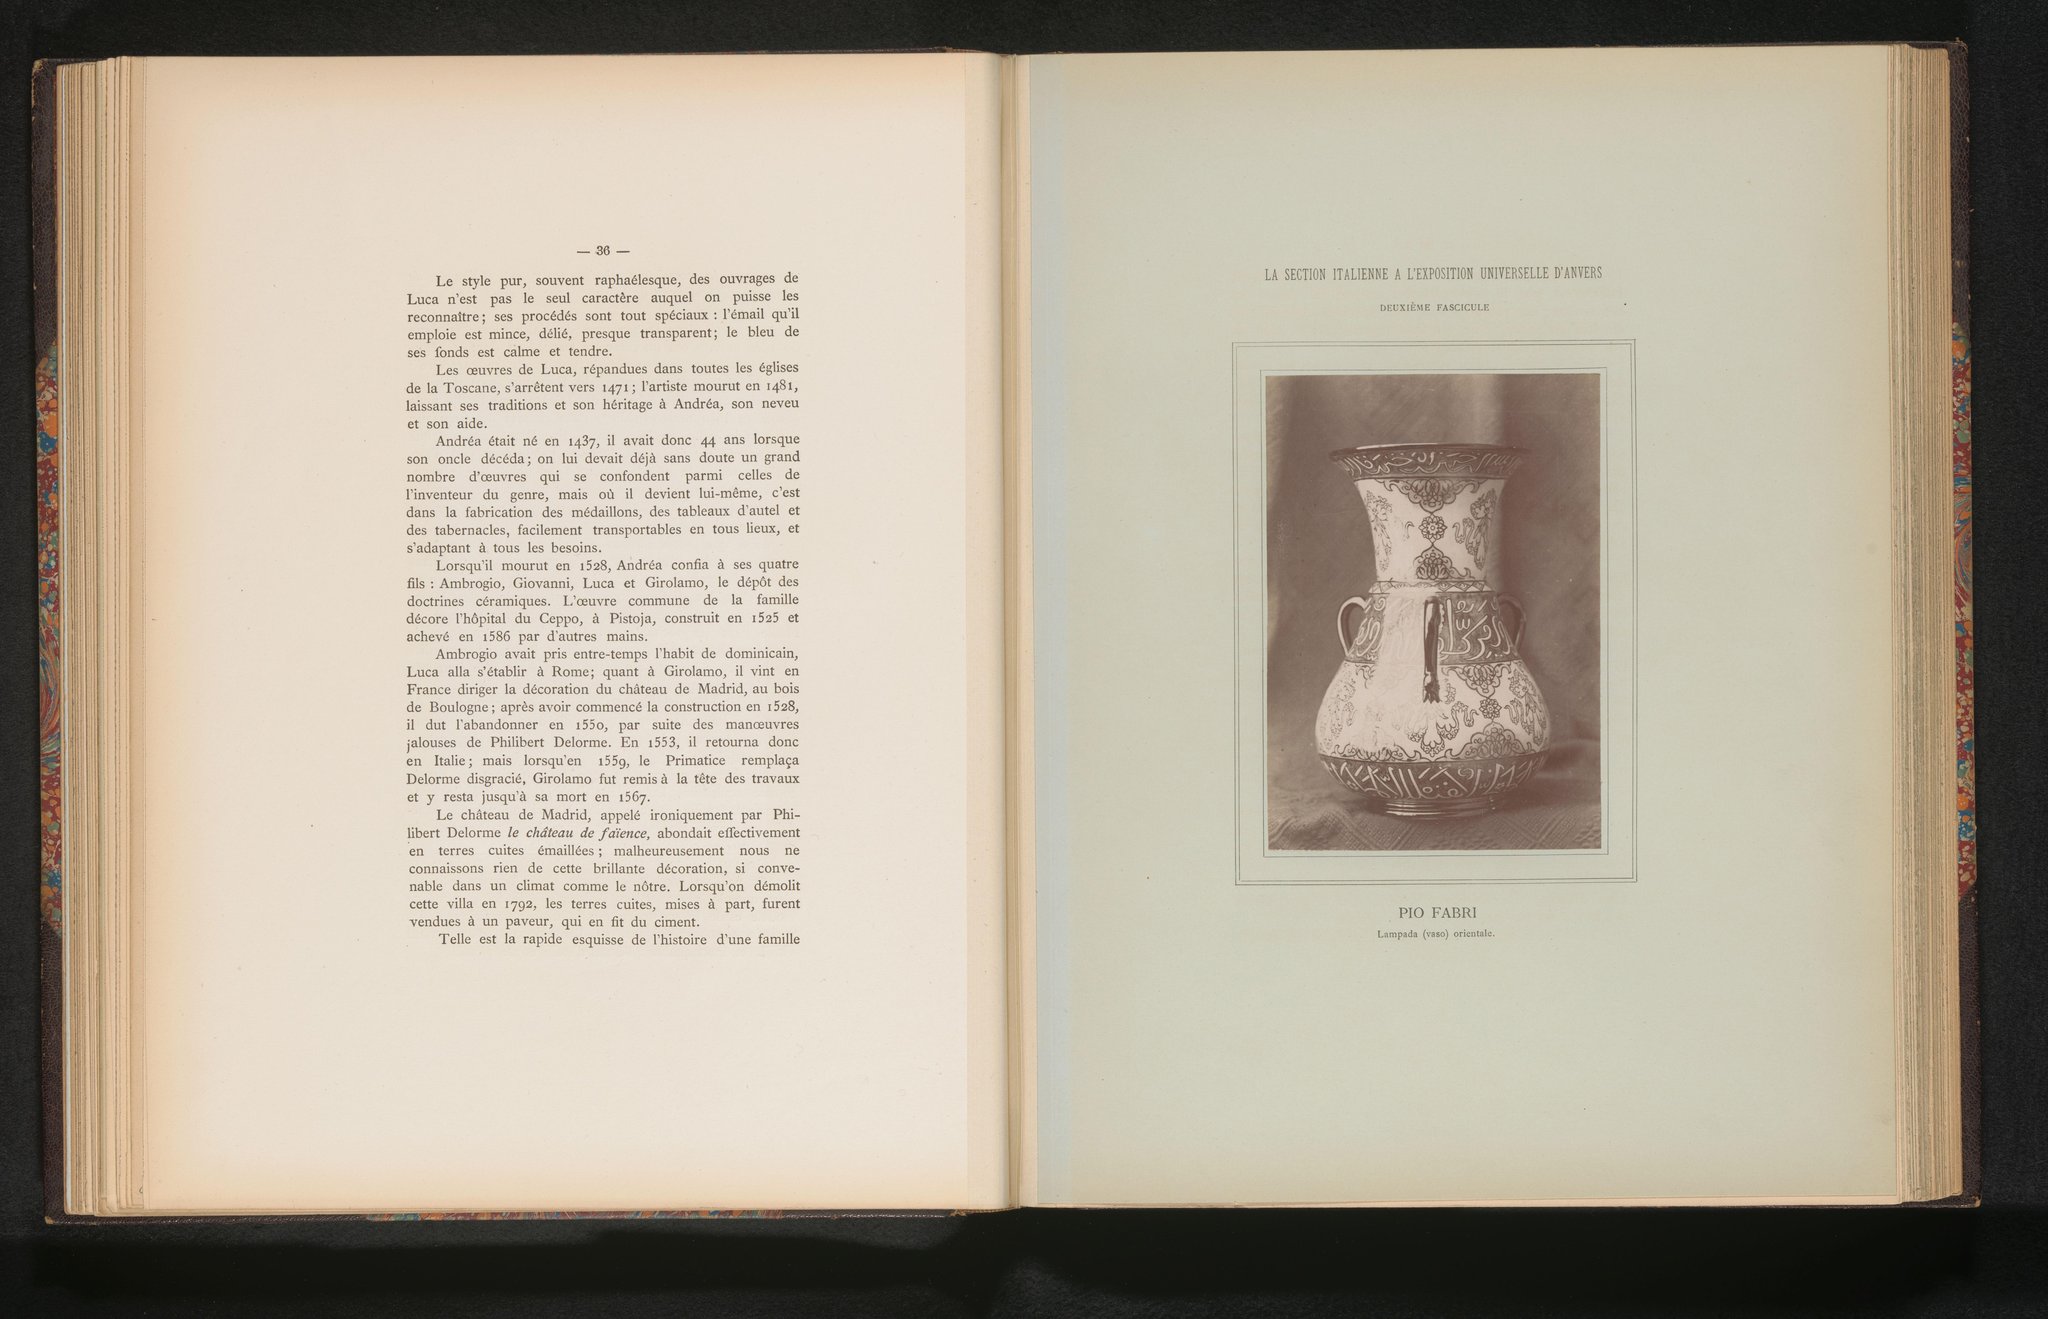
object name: photograph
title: Gedecoreerde vaas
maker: Anonymous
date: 1880-1885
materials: photographic support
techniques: albumen print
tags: vase ~ ornament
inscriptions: inscription: ‘La section Italienne a l'exposition universelle d'Anvers/ premies fascicule’